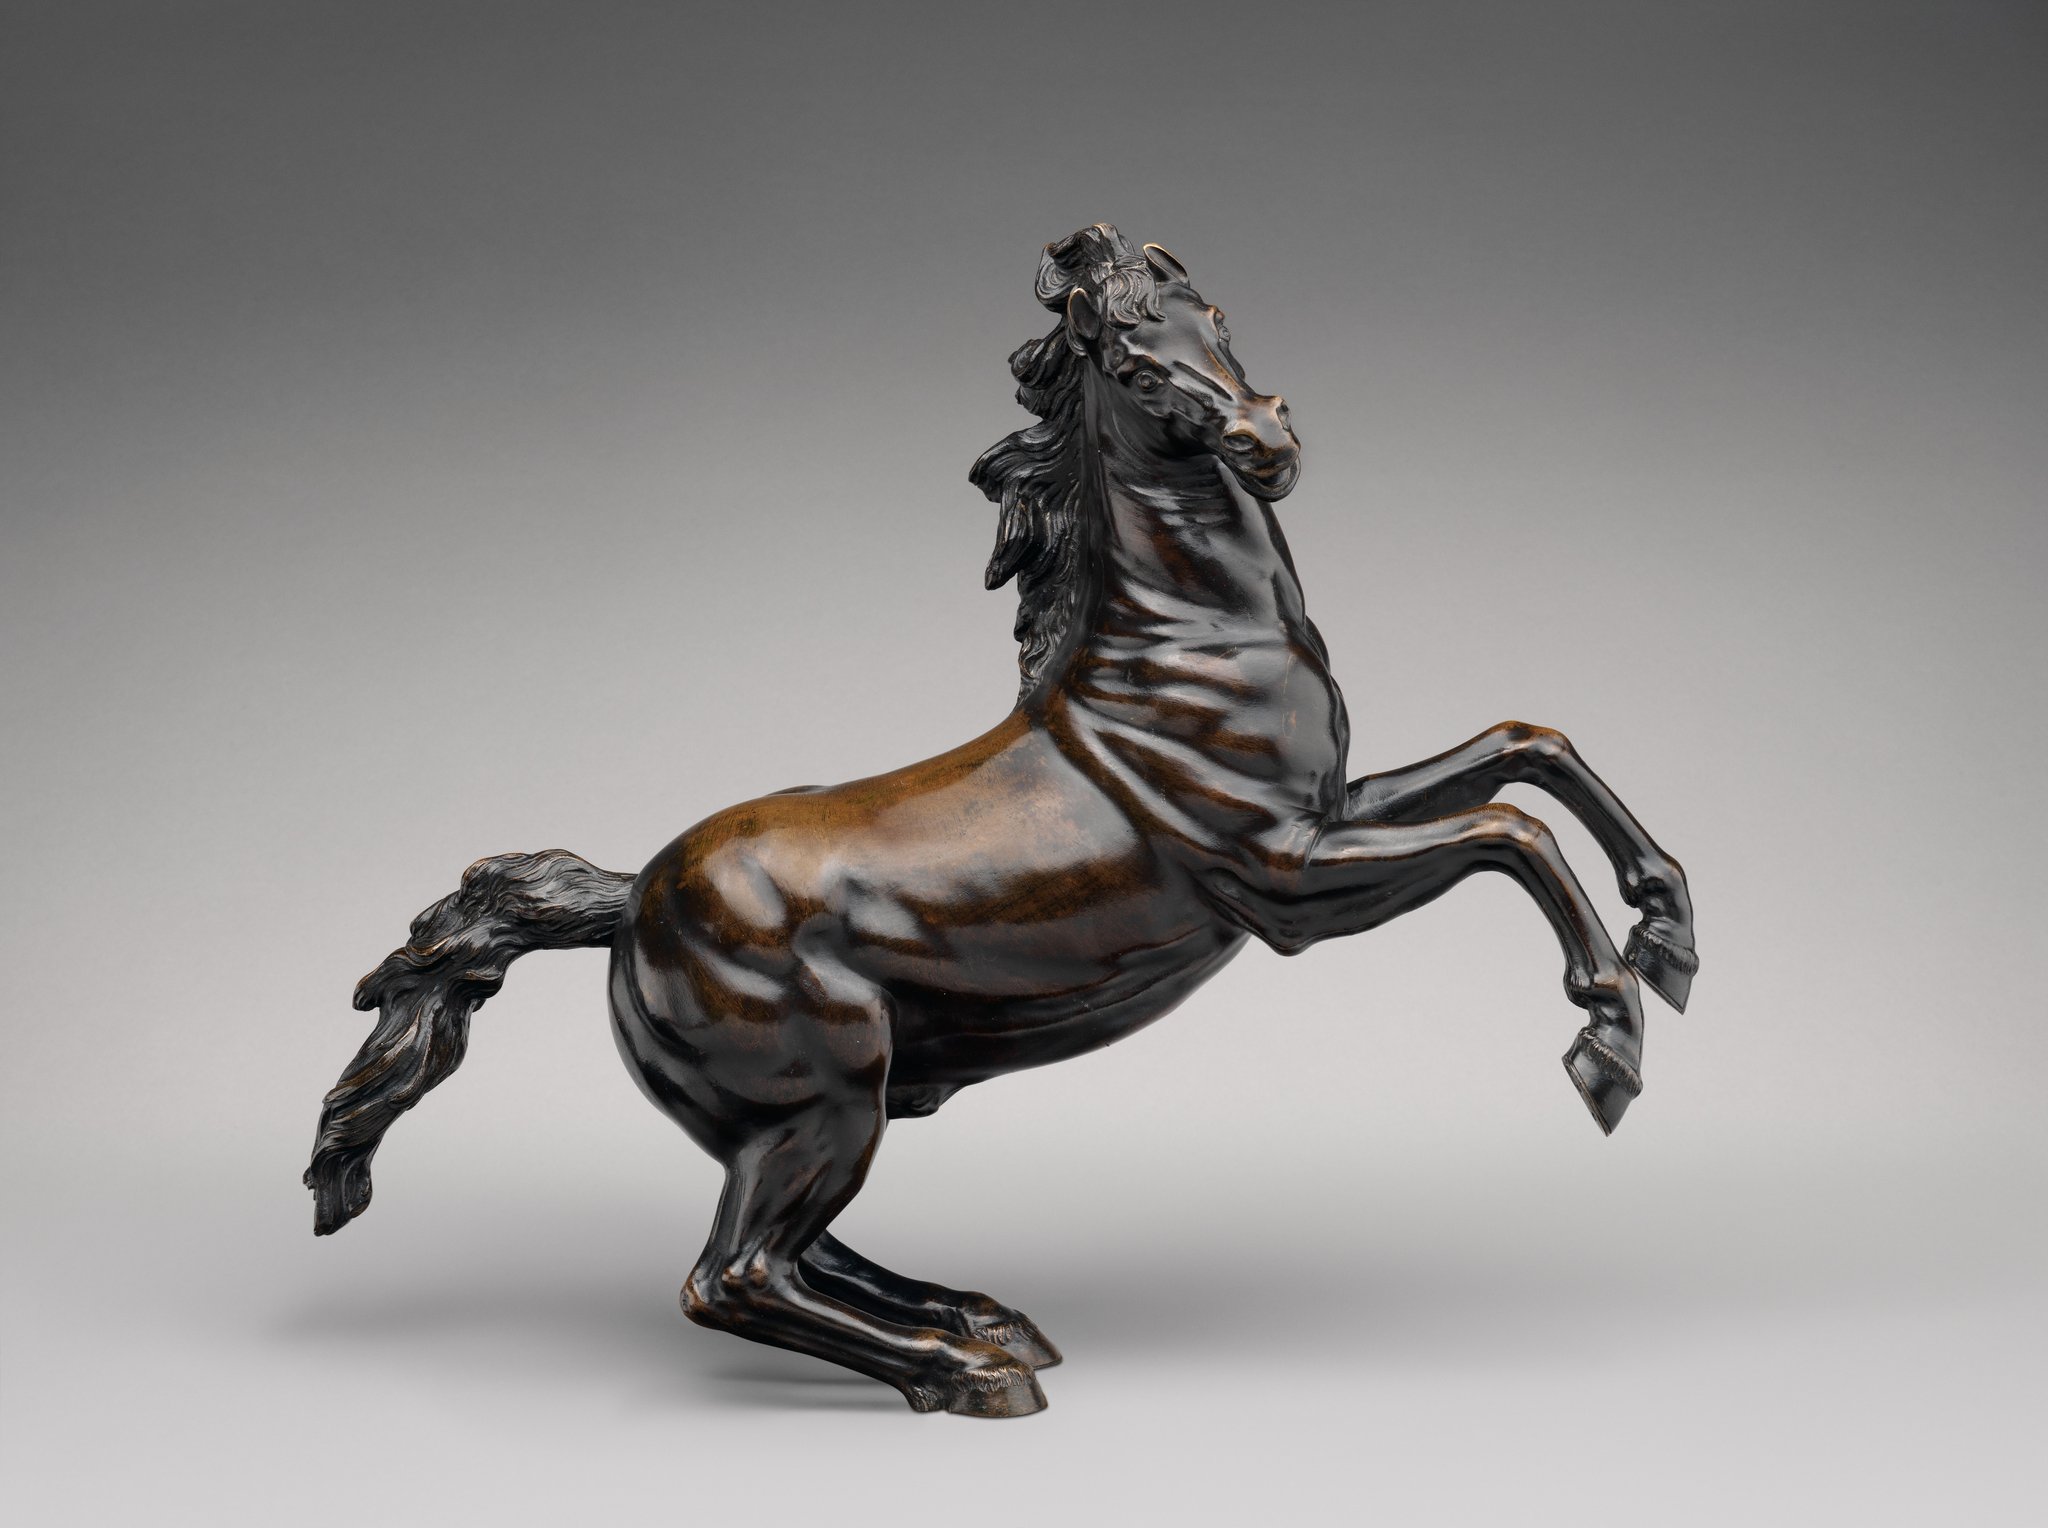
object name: statuette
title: Rearing Horse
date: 1667-1700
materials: bronze, lacquer, patina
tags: horses